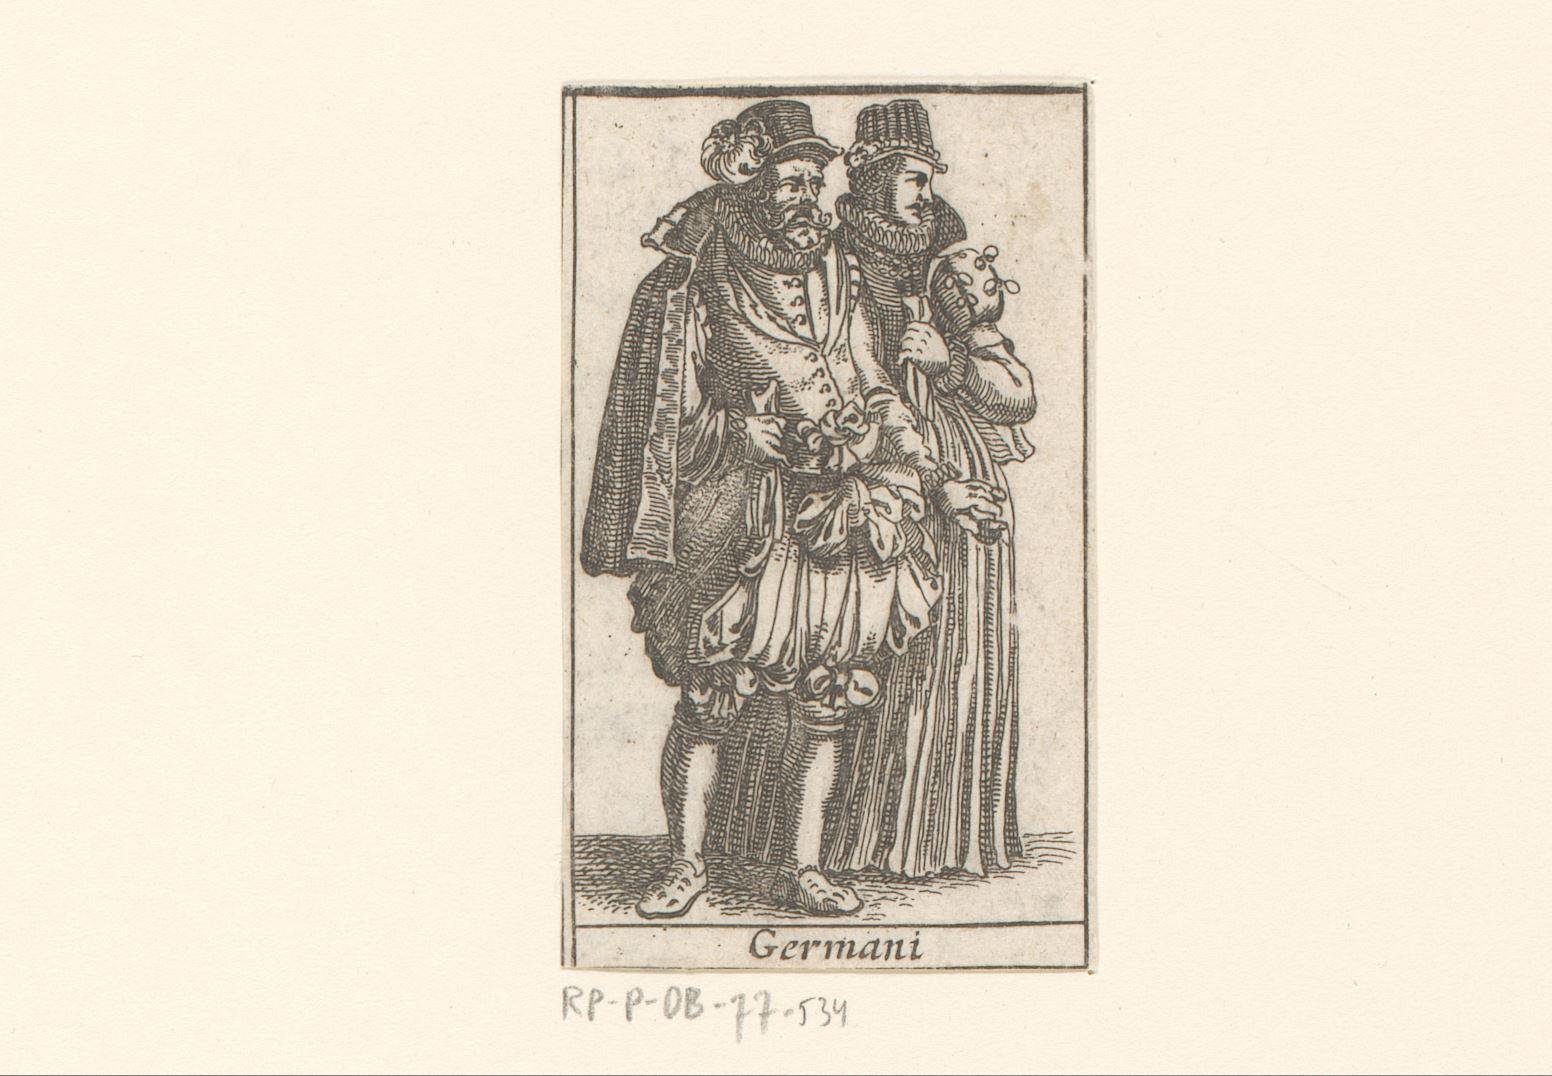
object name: print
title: Man en vrouw in Duitse mode van rond 1610-1620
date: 1617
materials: paper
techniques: etching, letterpress printing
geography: low countries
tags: europeans: germans (+ costume), clothes, costume, germany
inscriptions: collector's mark: Lugt 2228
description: Prent is geknipt van de kaart van Europa van Willem Jansz. Blaeu uit 1617.